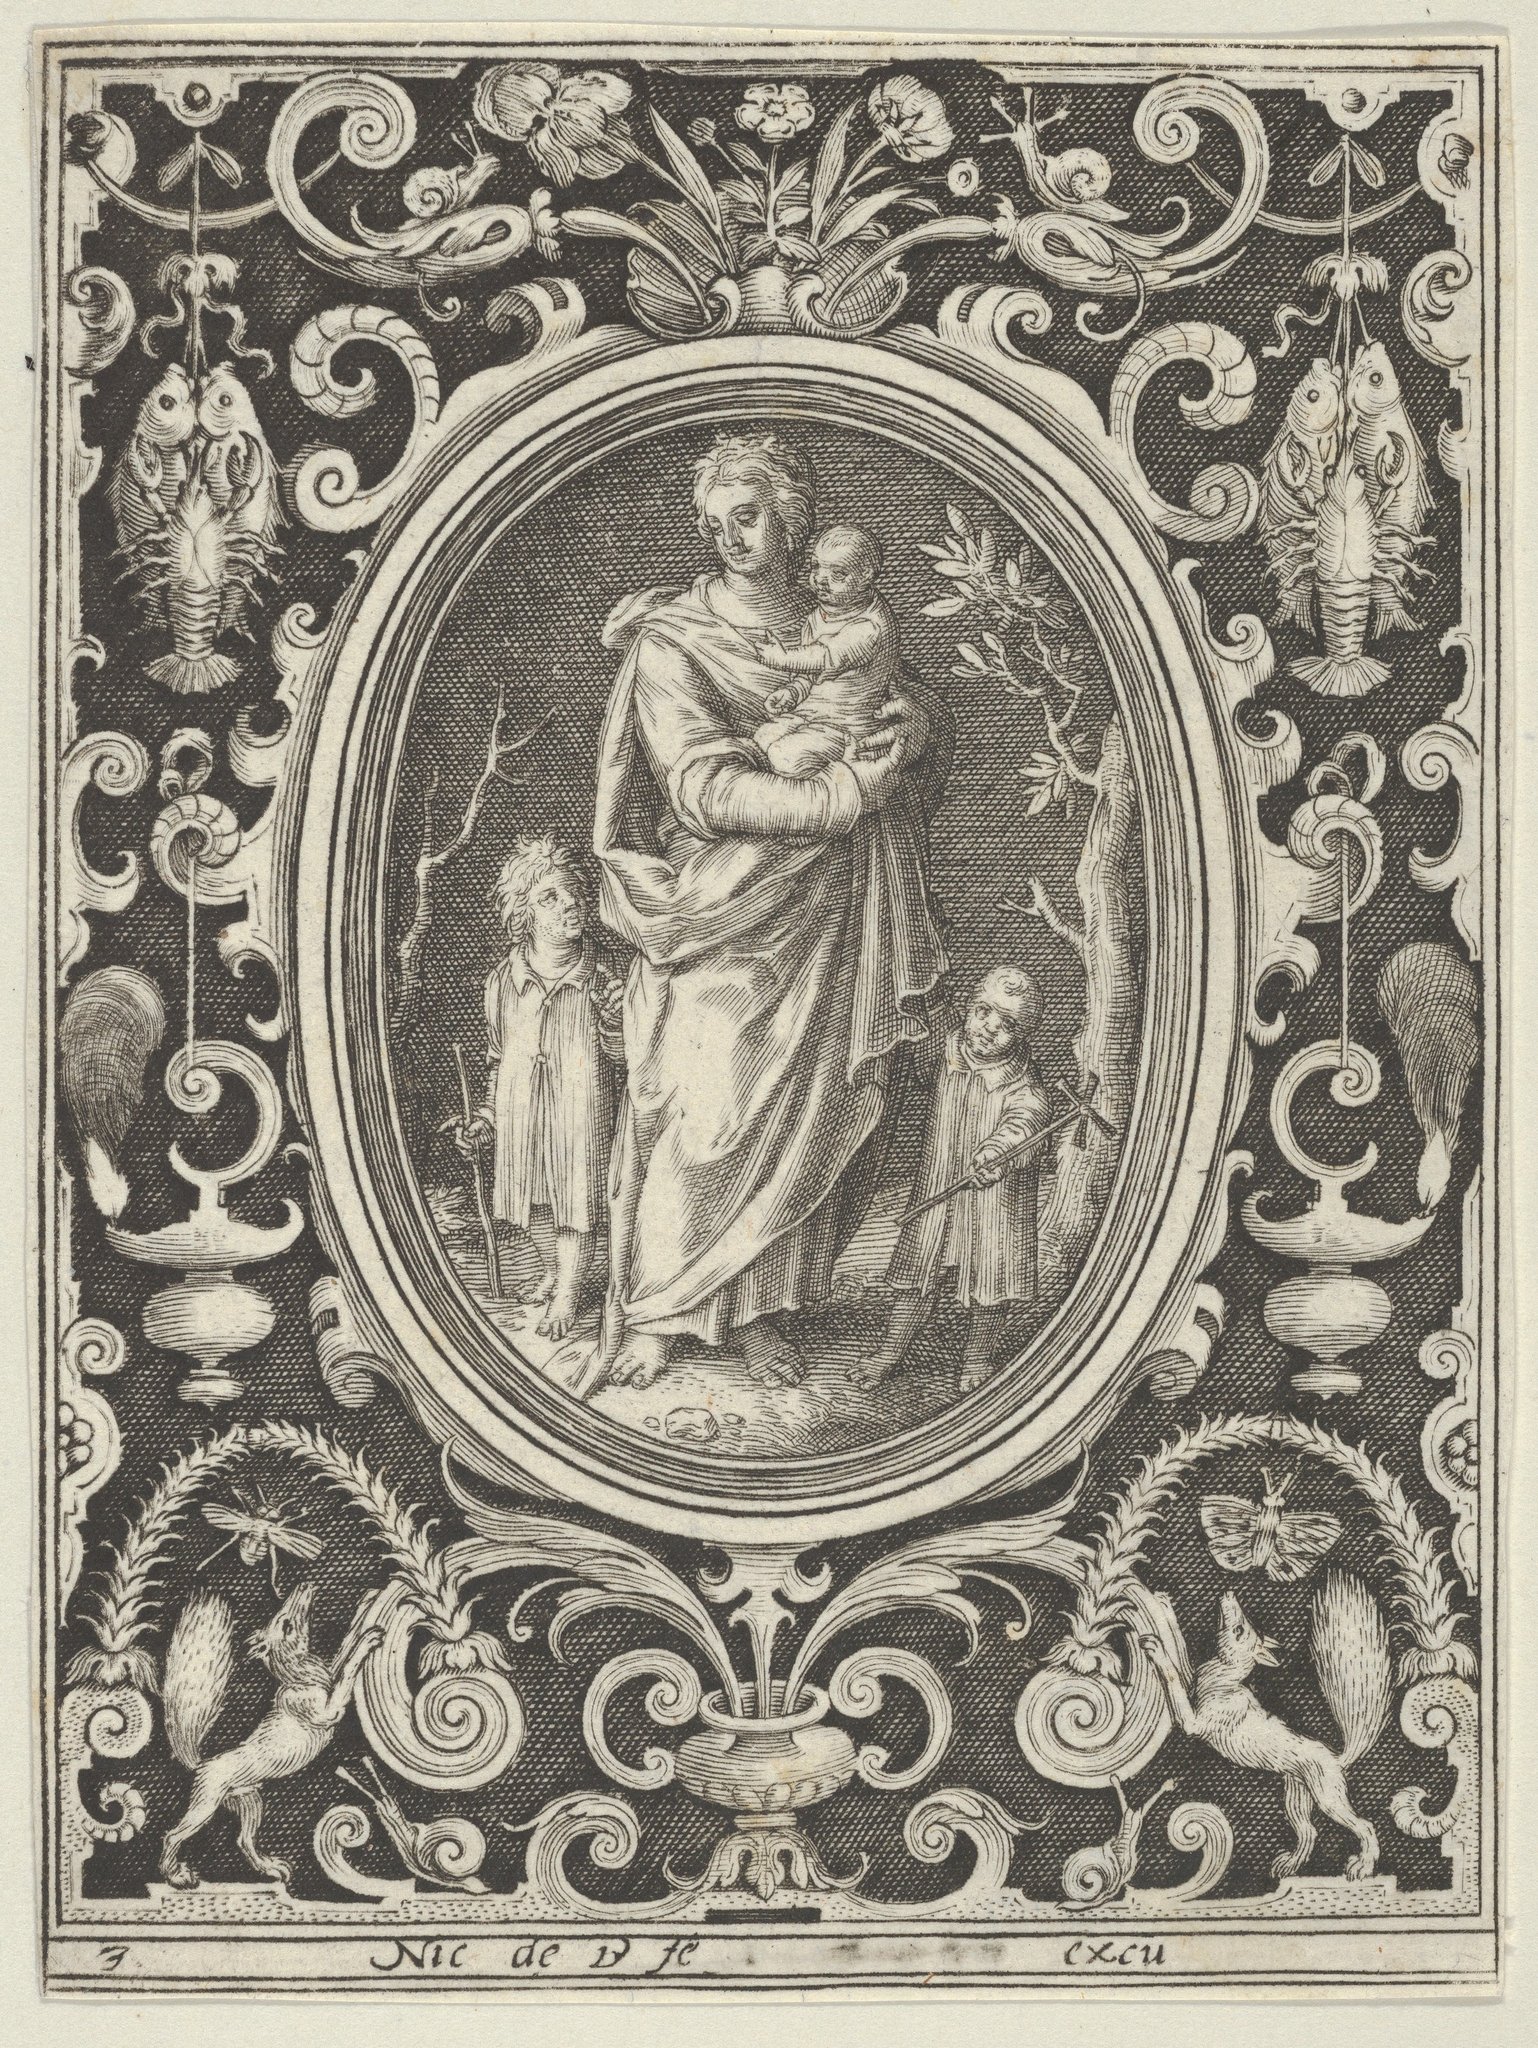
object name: print ornament architecture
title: Charity, from the Cardinal Virtues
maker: nicolaes de bruyn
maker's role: artist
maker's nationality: netherlandish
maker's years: 1571-1656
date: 1648-1656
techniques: engraving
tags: children,women,fish,foxes,snails,lobsters